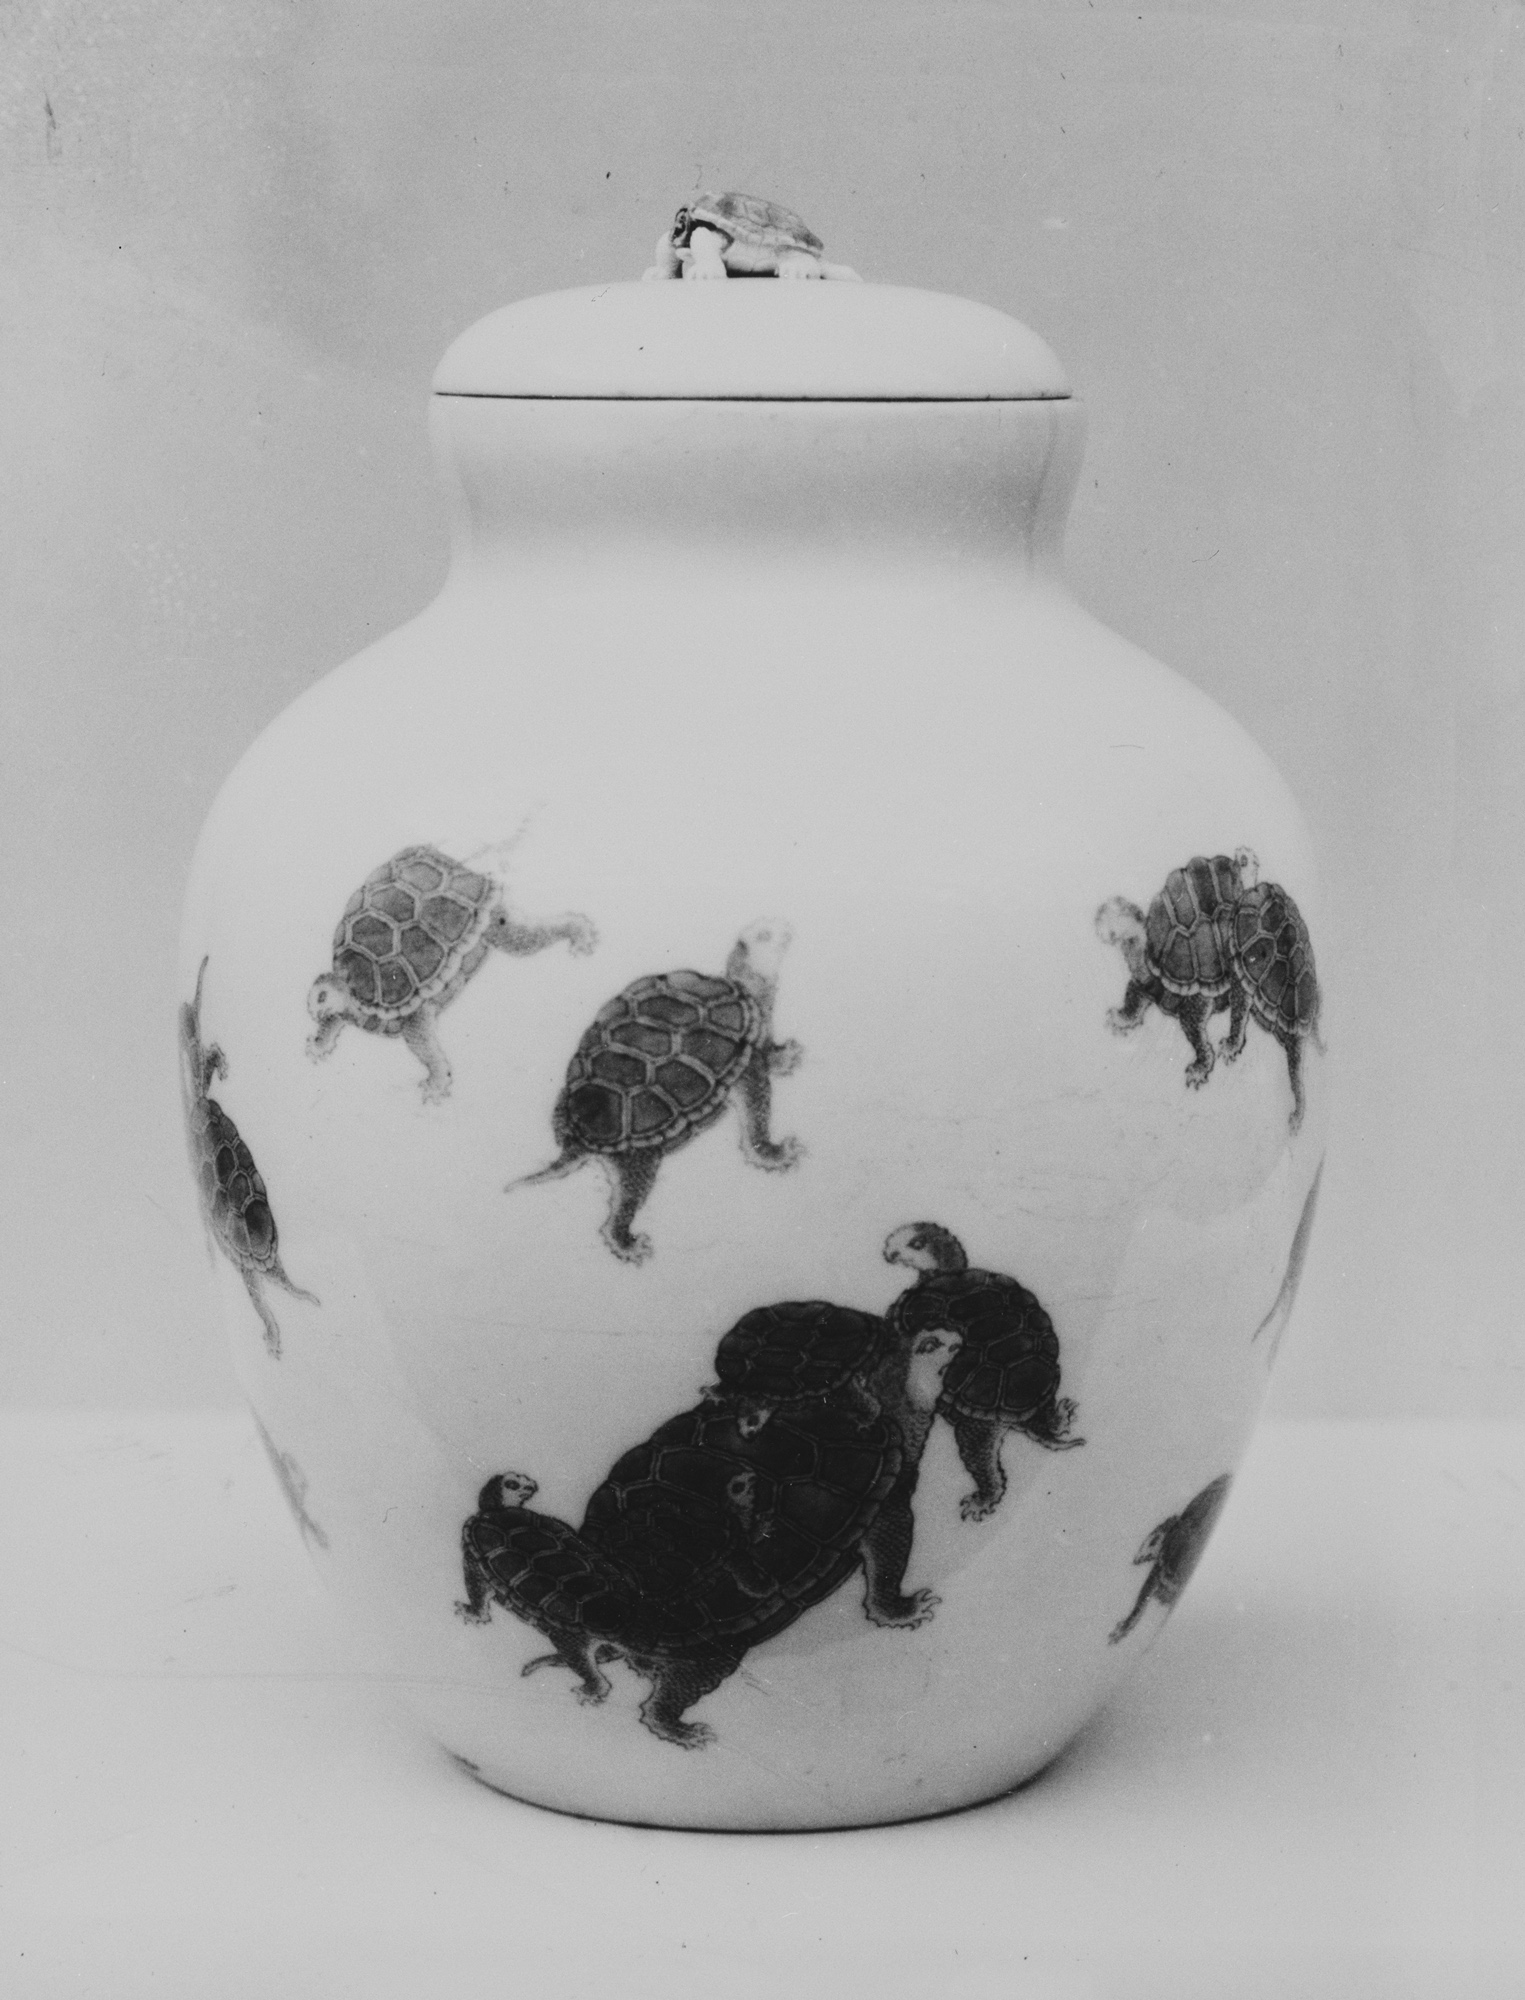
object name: jar with cover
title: Jar and cover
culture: japanese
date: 1850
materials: porcelain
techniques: underglaze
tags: turtles